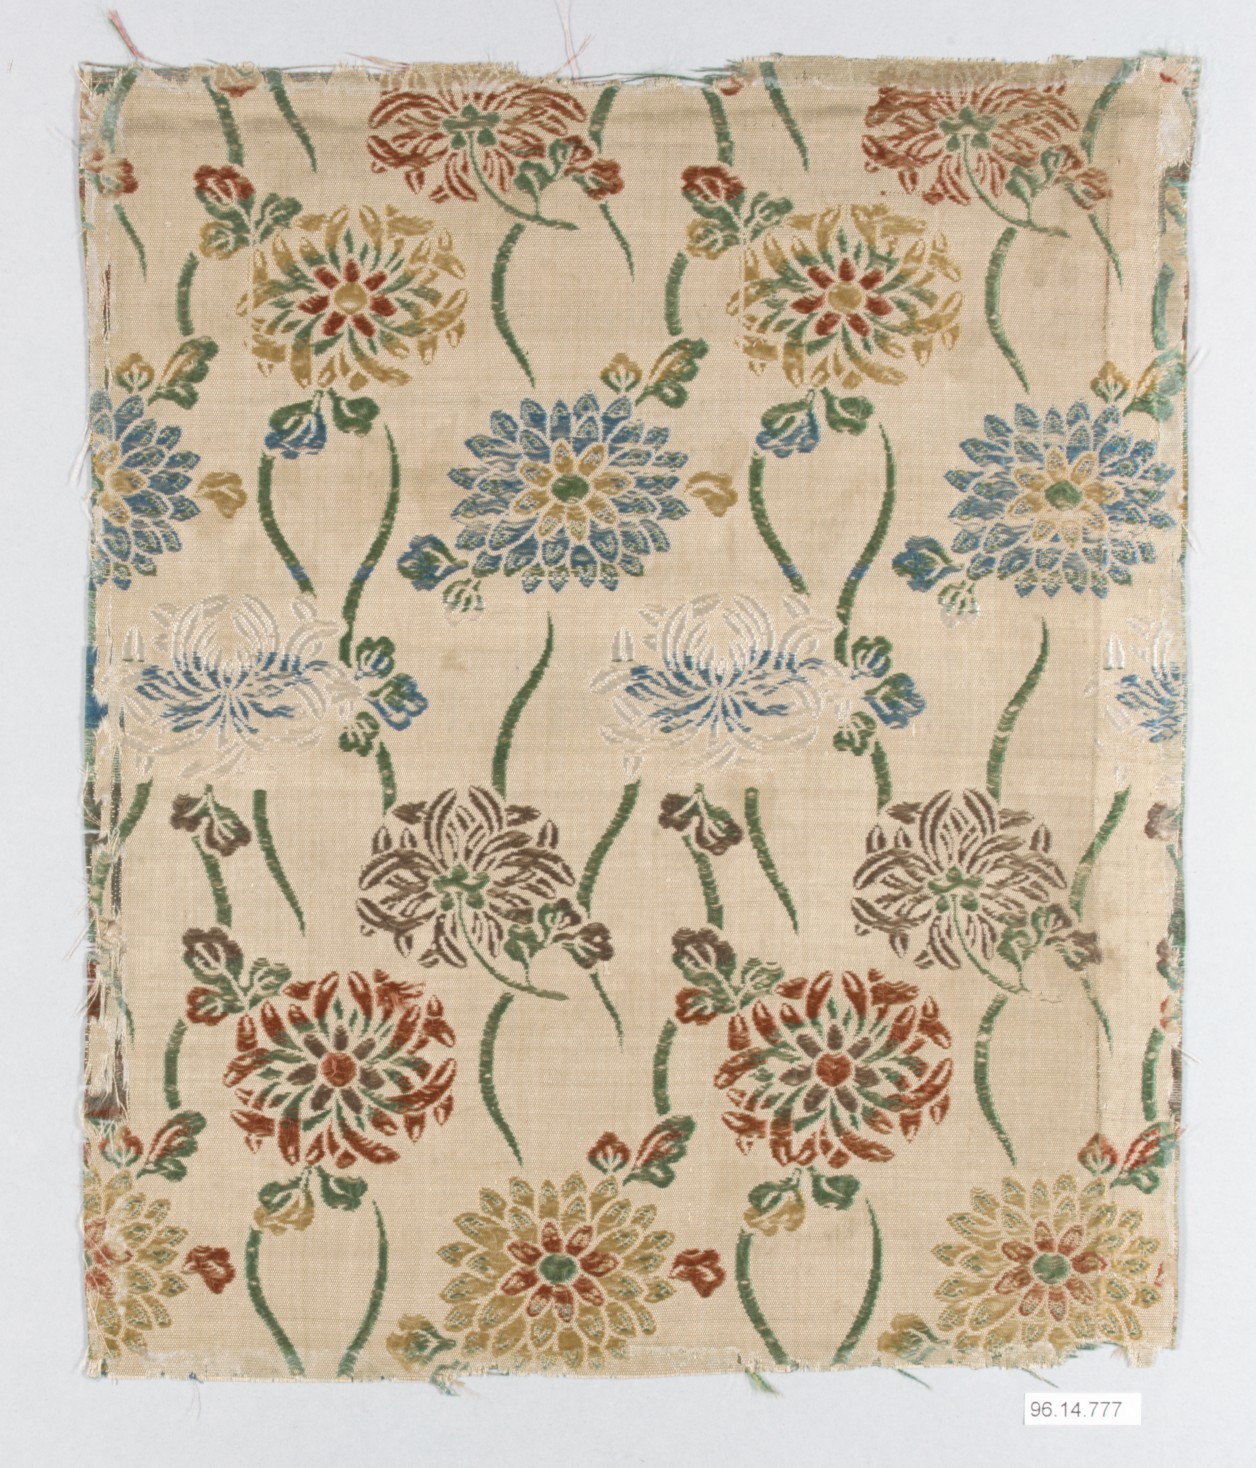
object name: piece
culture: japanese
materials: metal thread, silk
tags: flowers